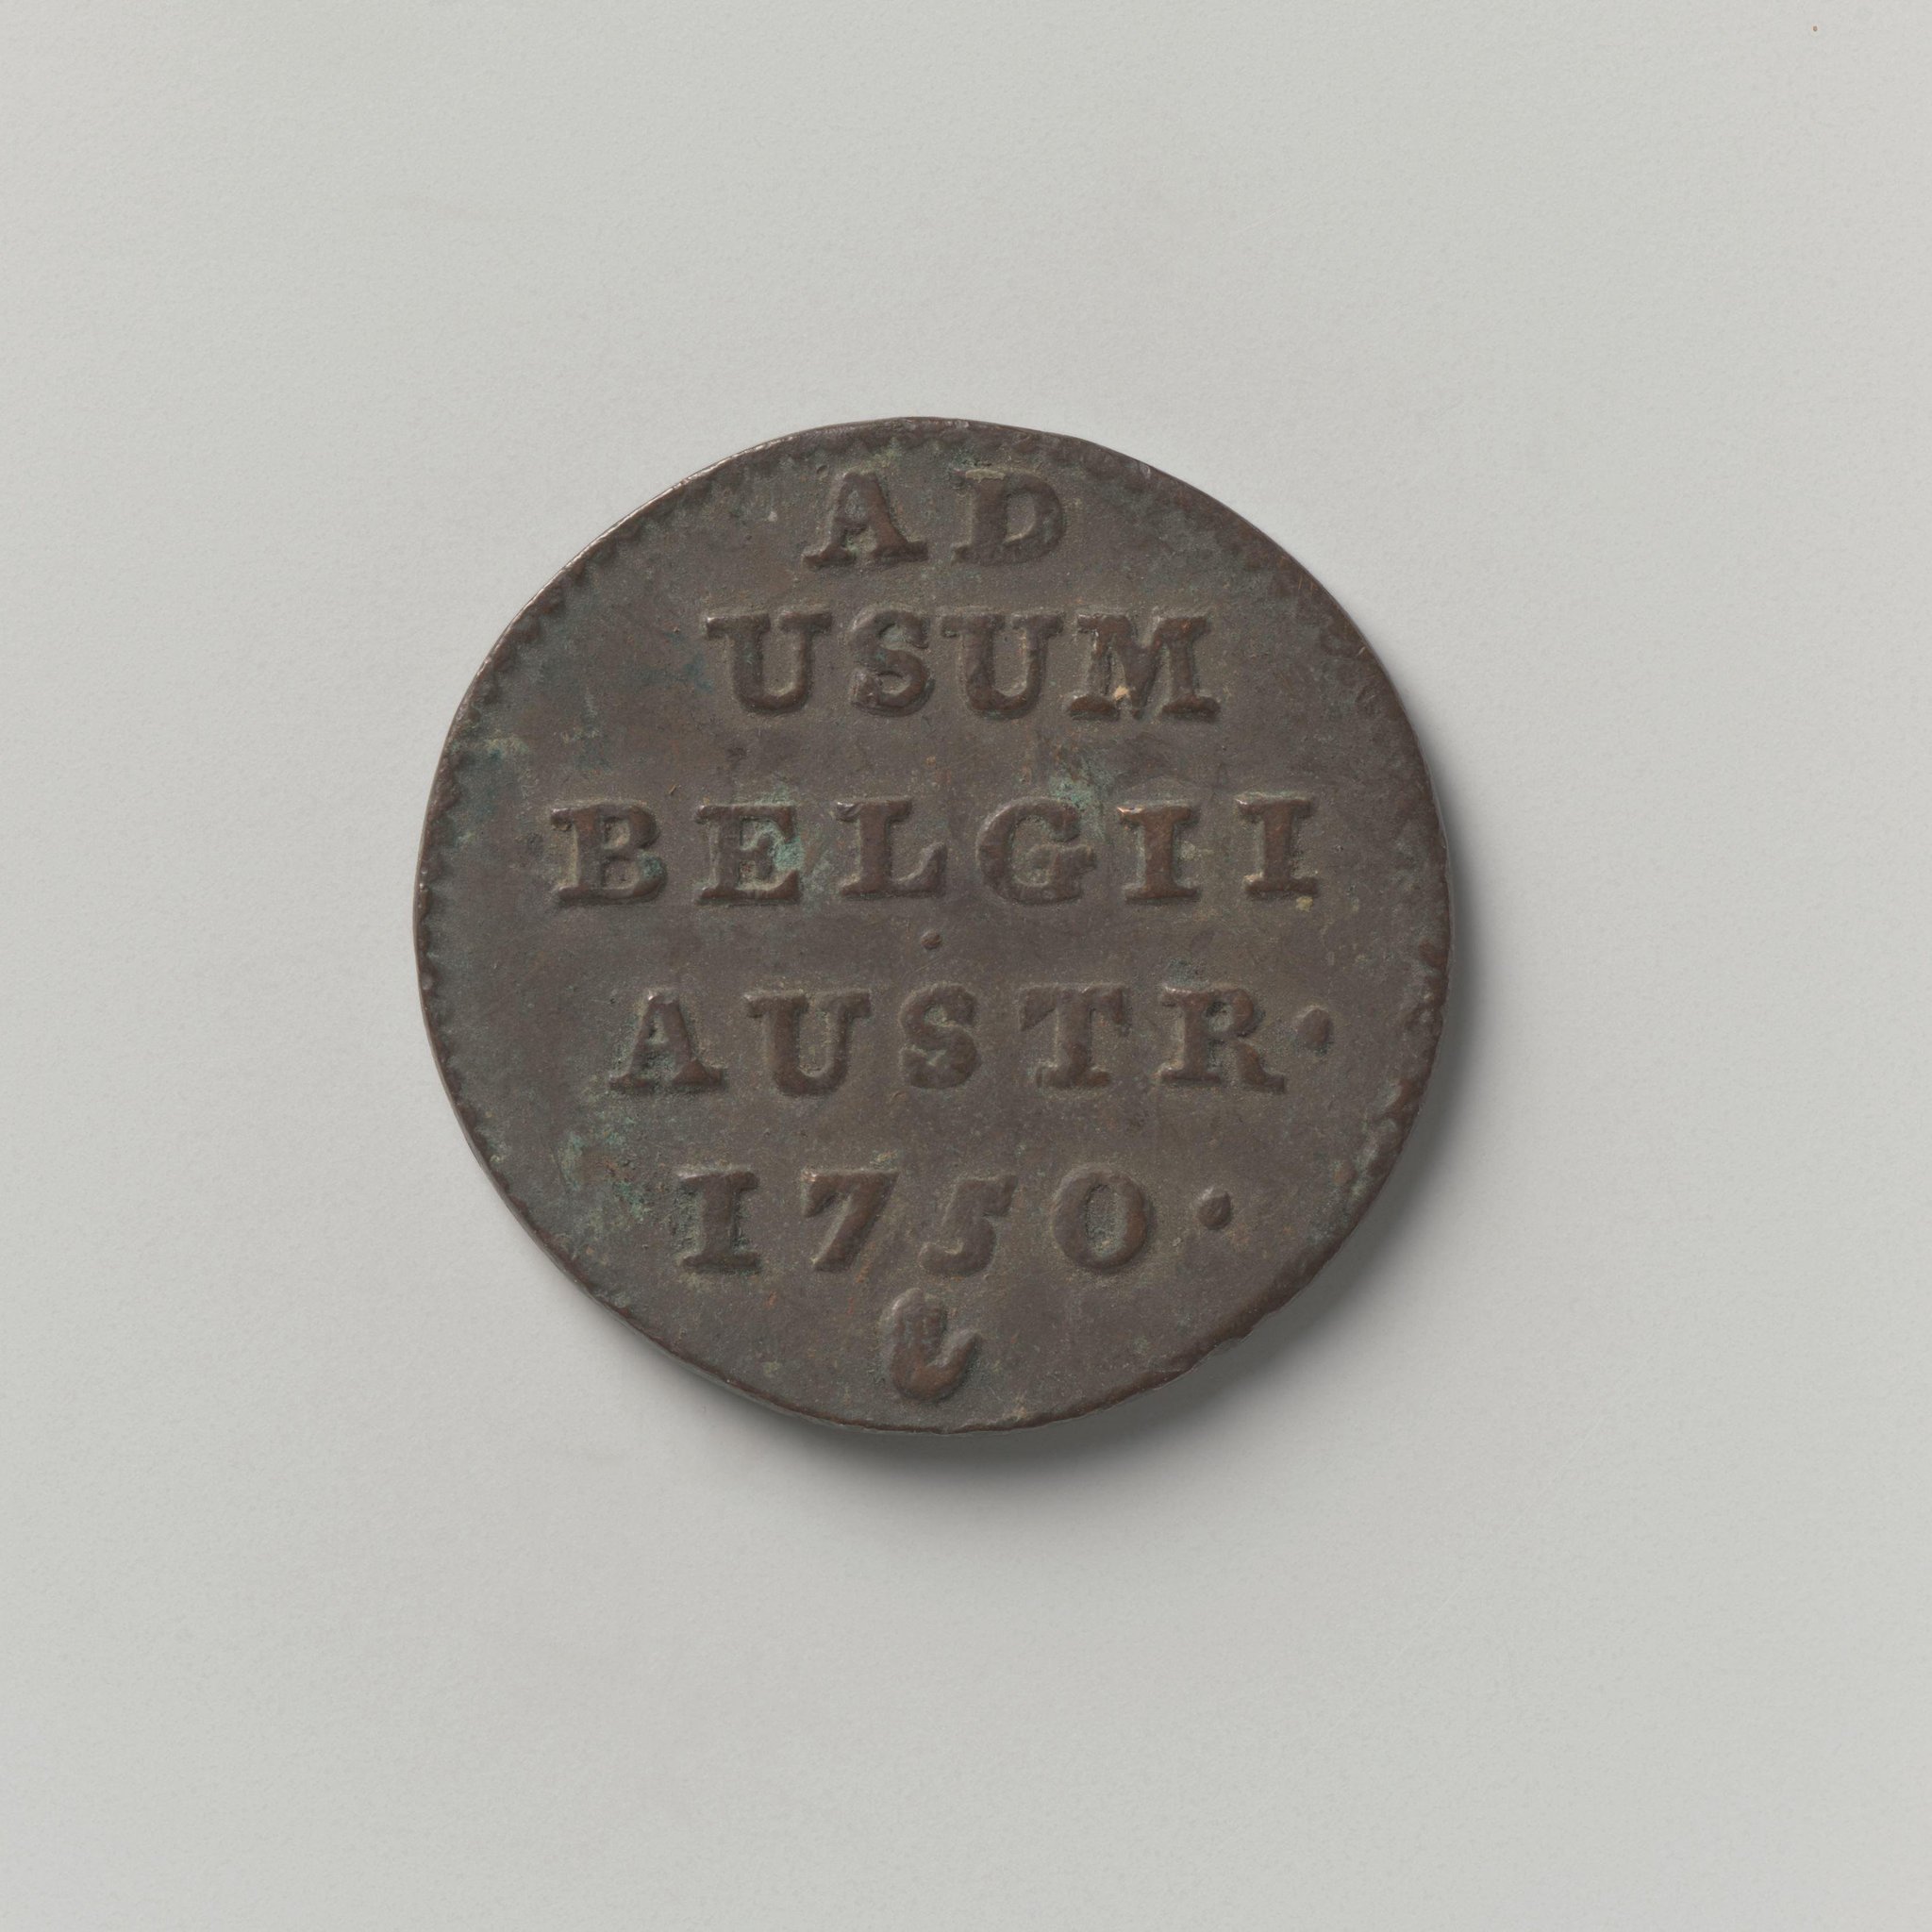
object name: oord, oortje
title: Oord uit Brabant van Maria-Theresia,1750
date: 1750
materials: copper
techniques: striking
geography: antwerp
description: Koperen munt. Voorzijde: portret van Maria-Theresia naar rechts. Keerzijde: vierregelig opschrift, waaronder jaartal. Daaronder hand.